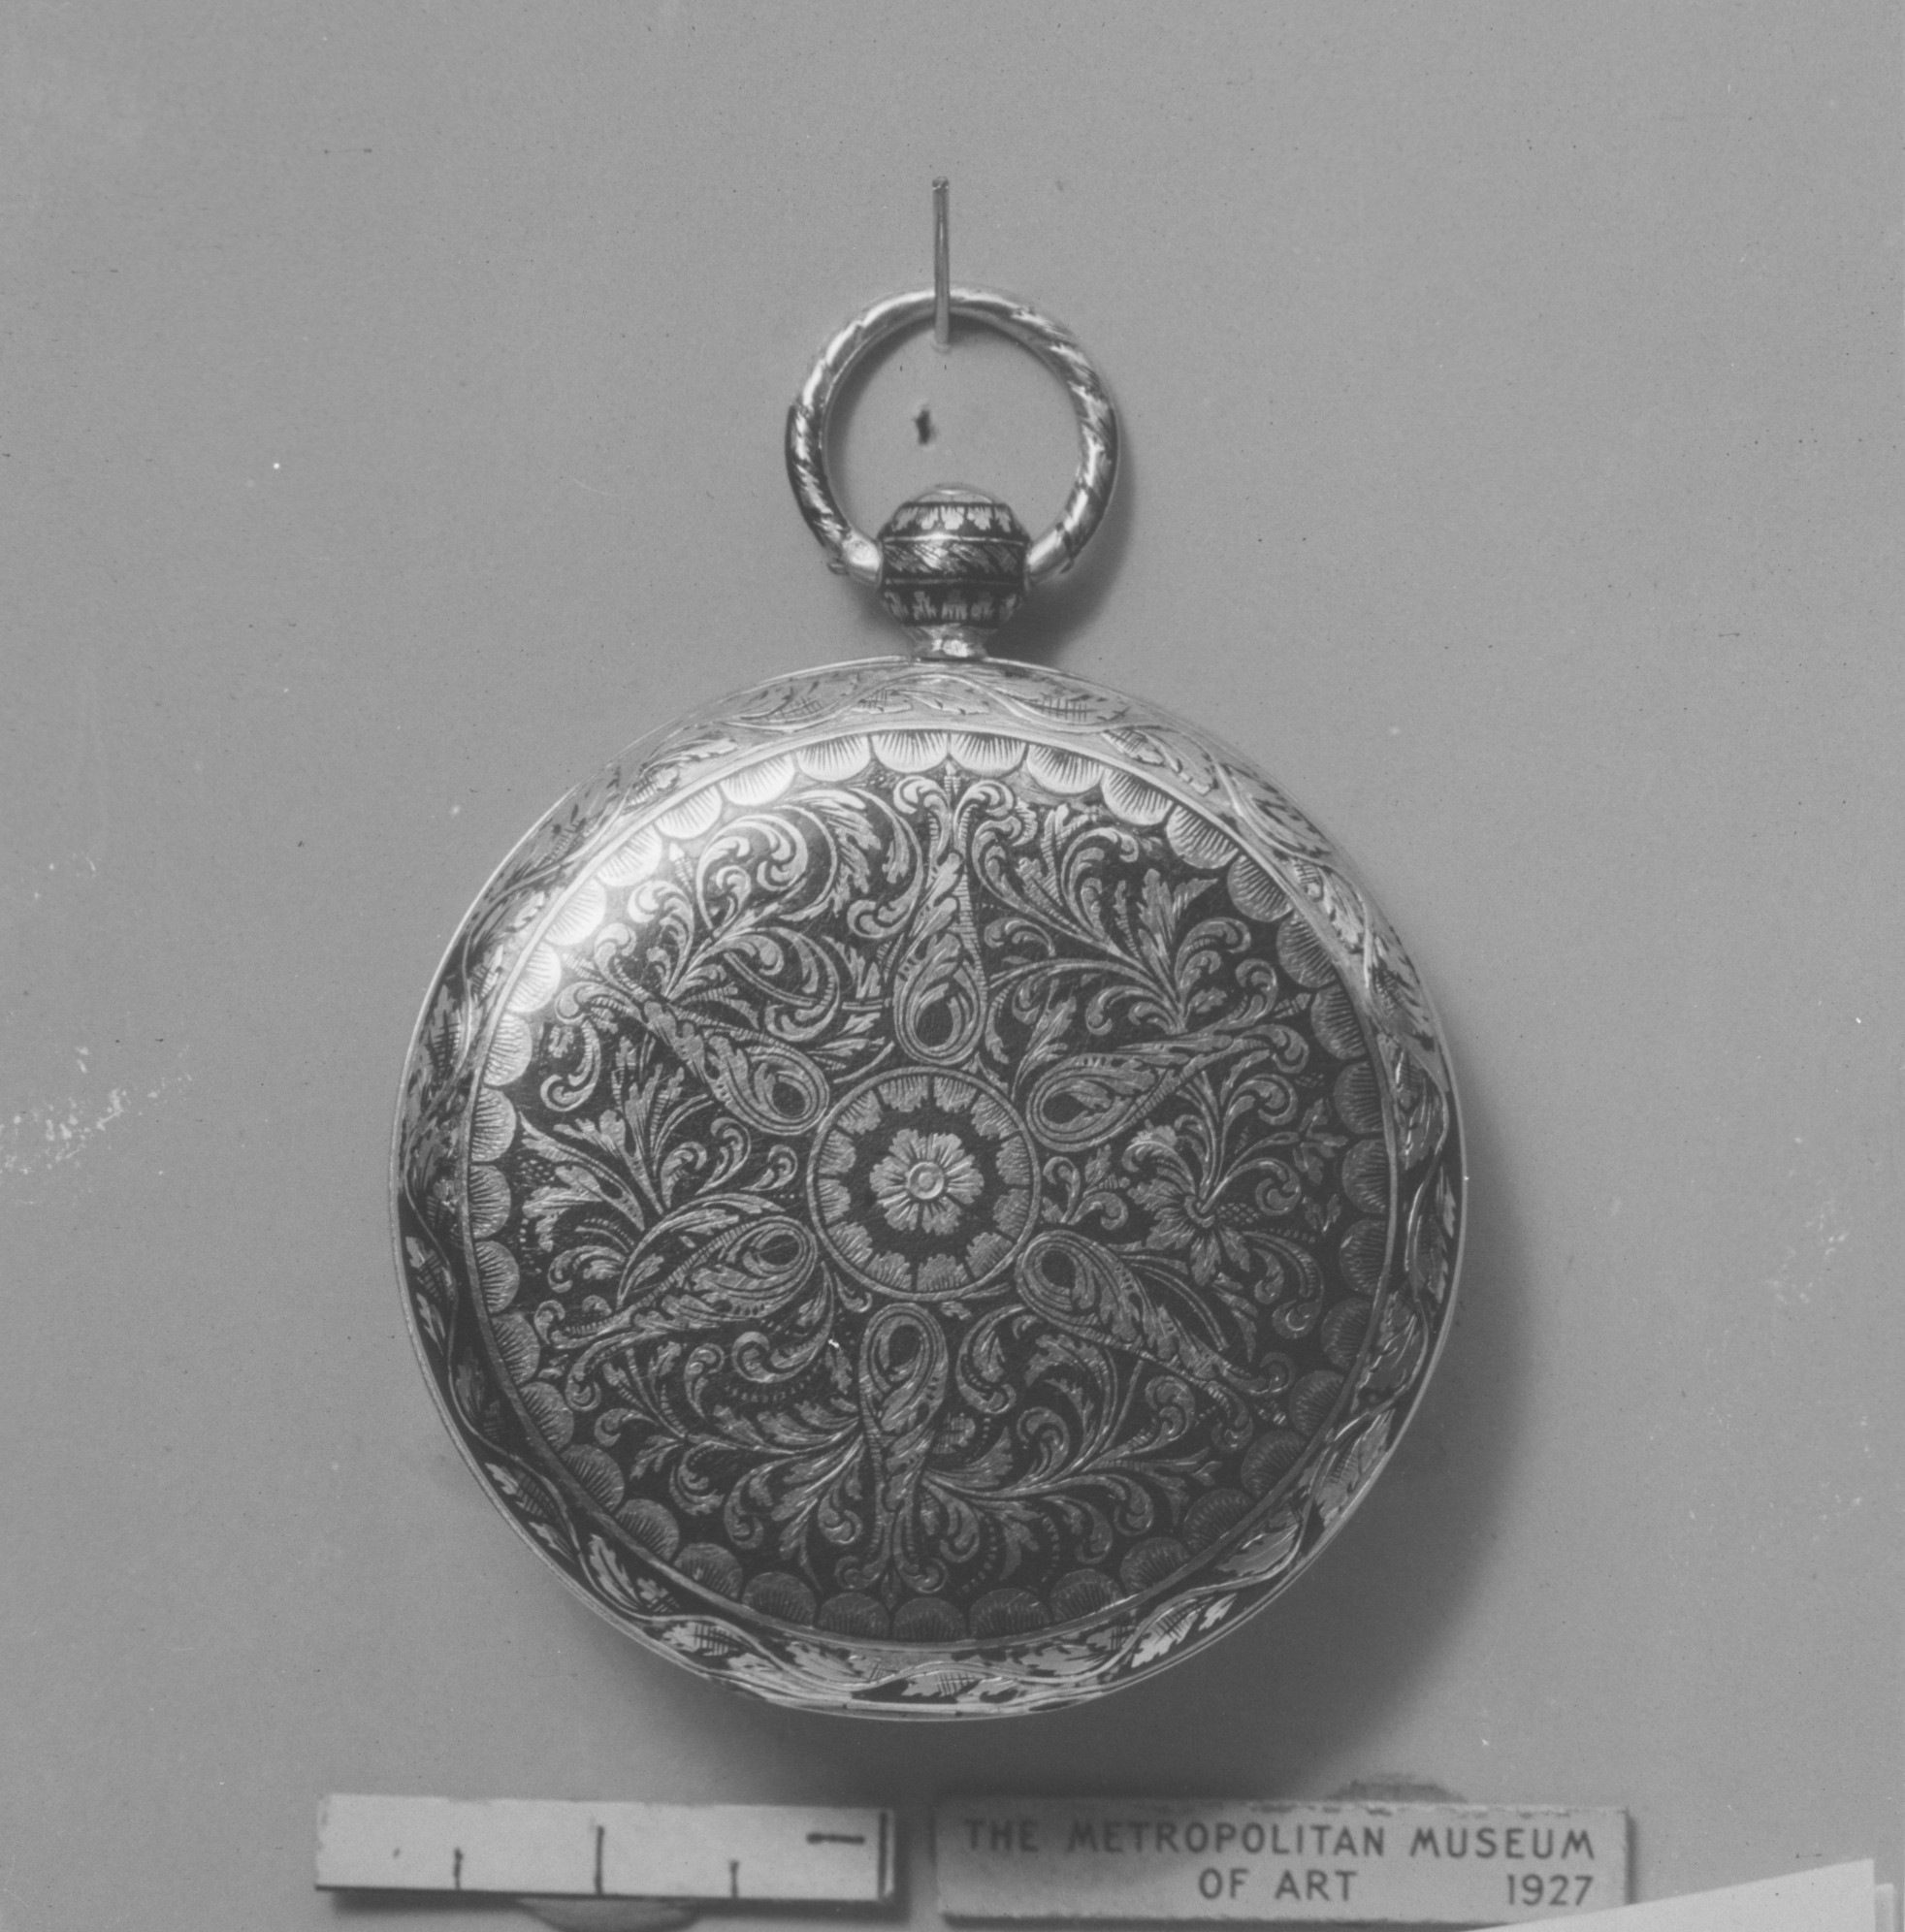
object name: watch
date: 1815-1840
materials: enamel, gold, silver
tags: flowers